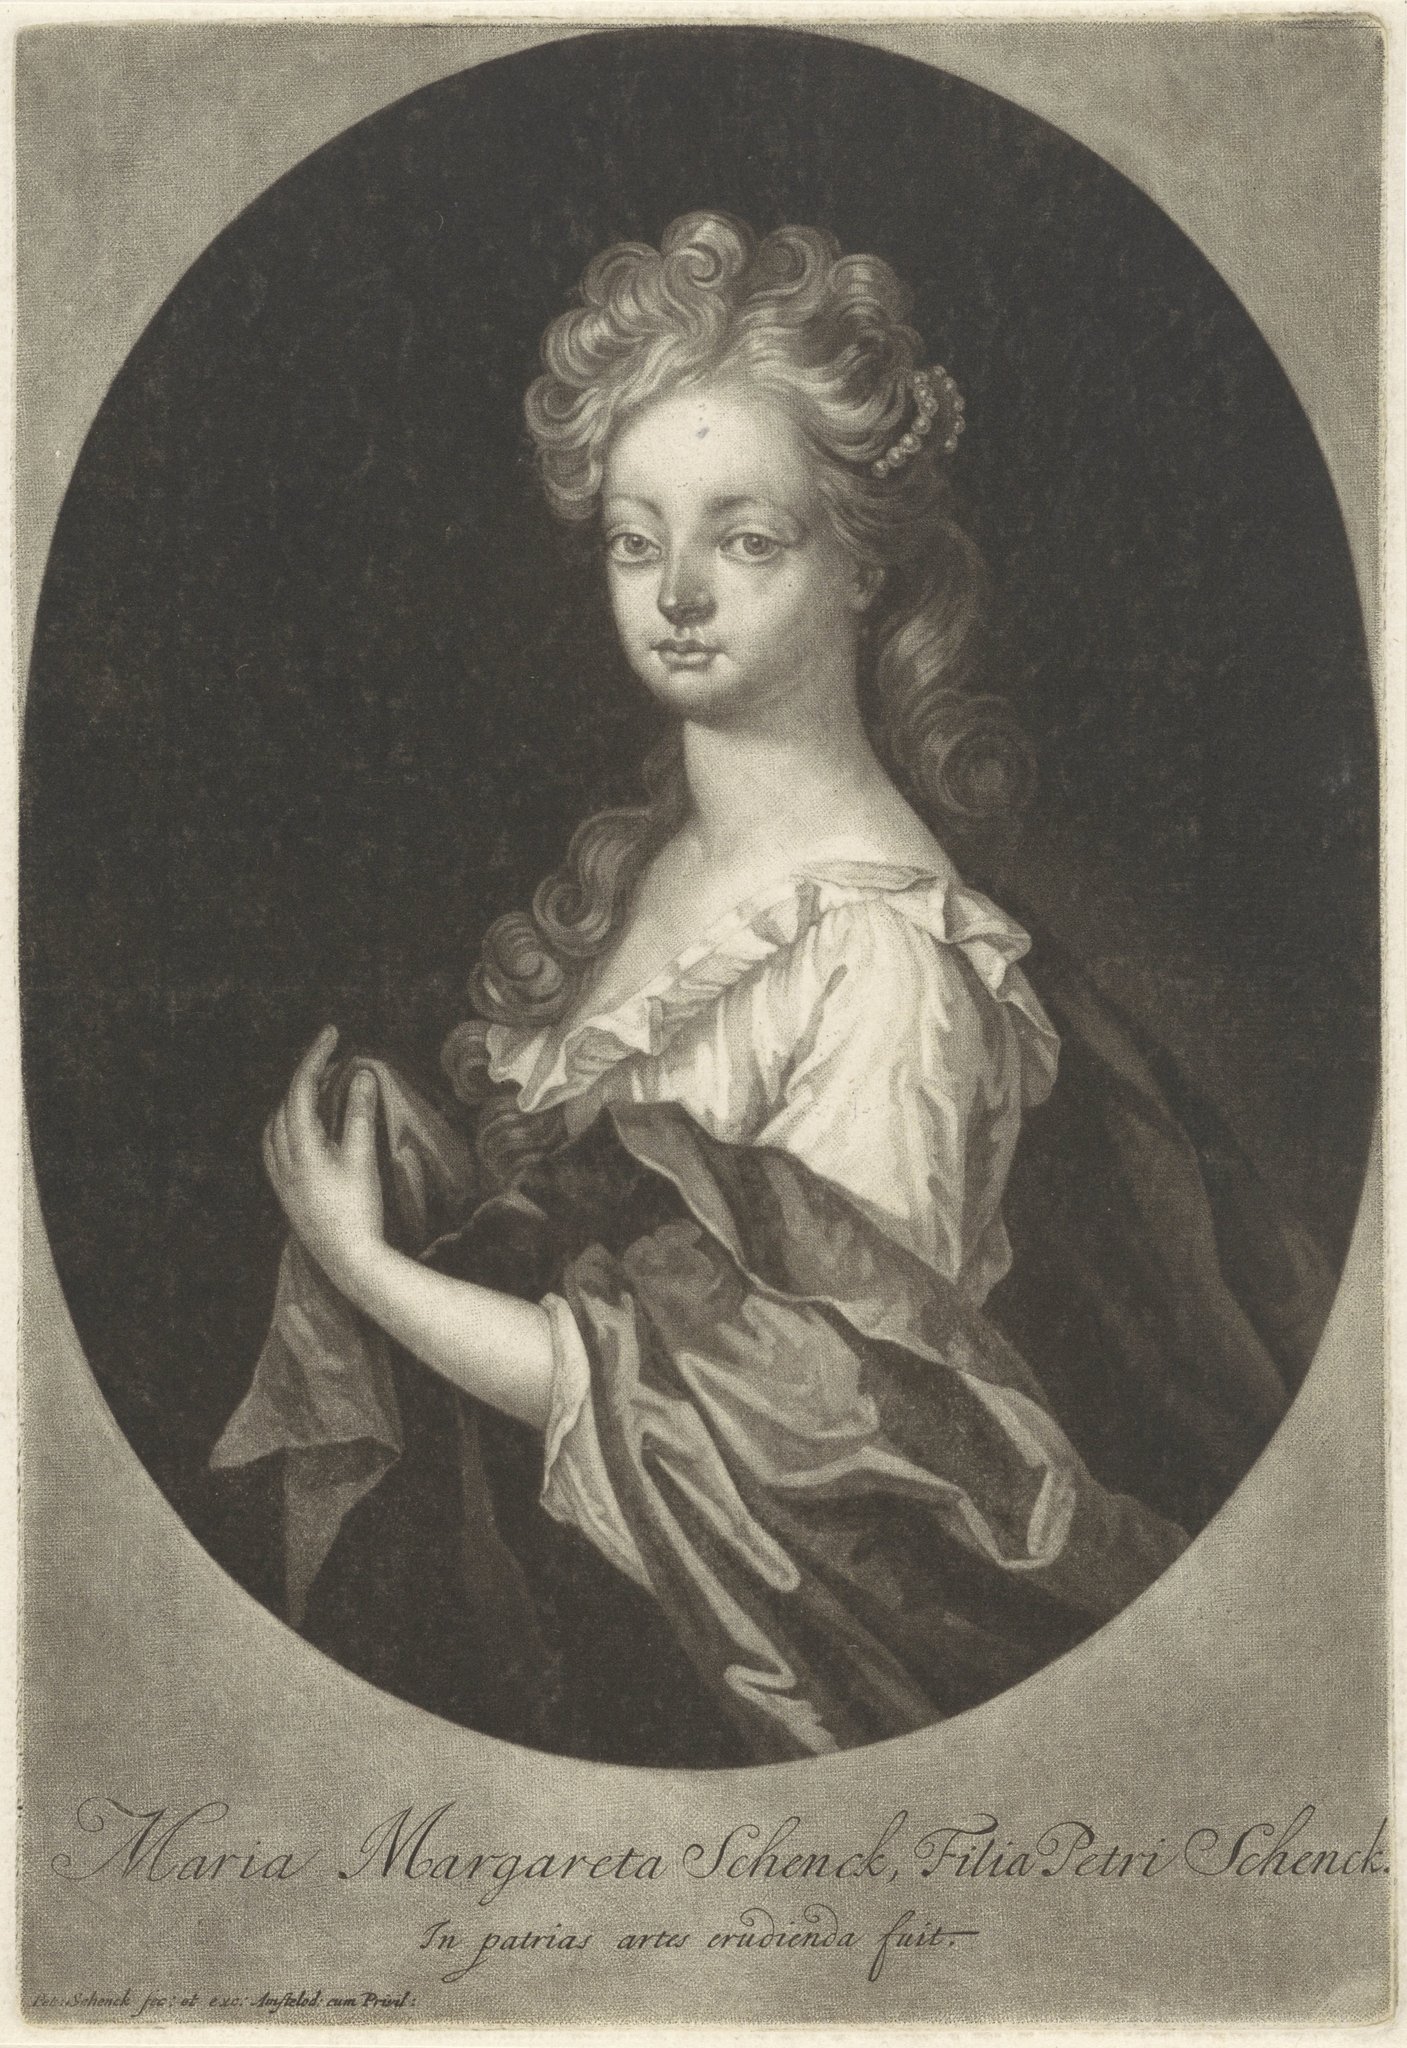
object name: print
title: Portret van Maria Margaretha Schenk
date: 1690-1713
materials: paper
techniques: engraving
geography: amsterdam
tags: pearl; pearl necklace (+ women's clothes)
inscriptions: collector's mark: Lugt 2228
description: Maria Margaretha Schenk, een van de dochters van de prentmaker Pieter Schenk, met parels in het haar.